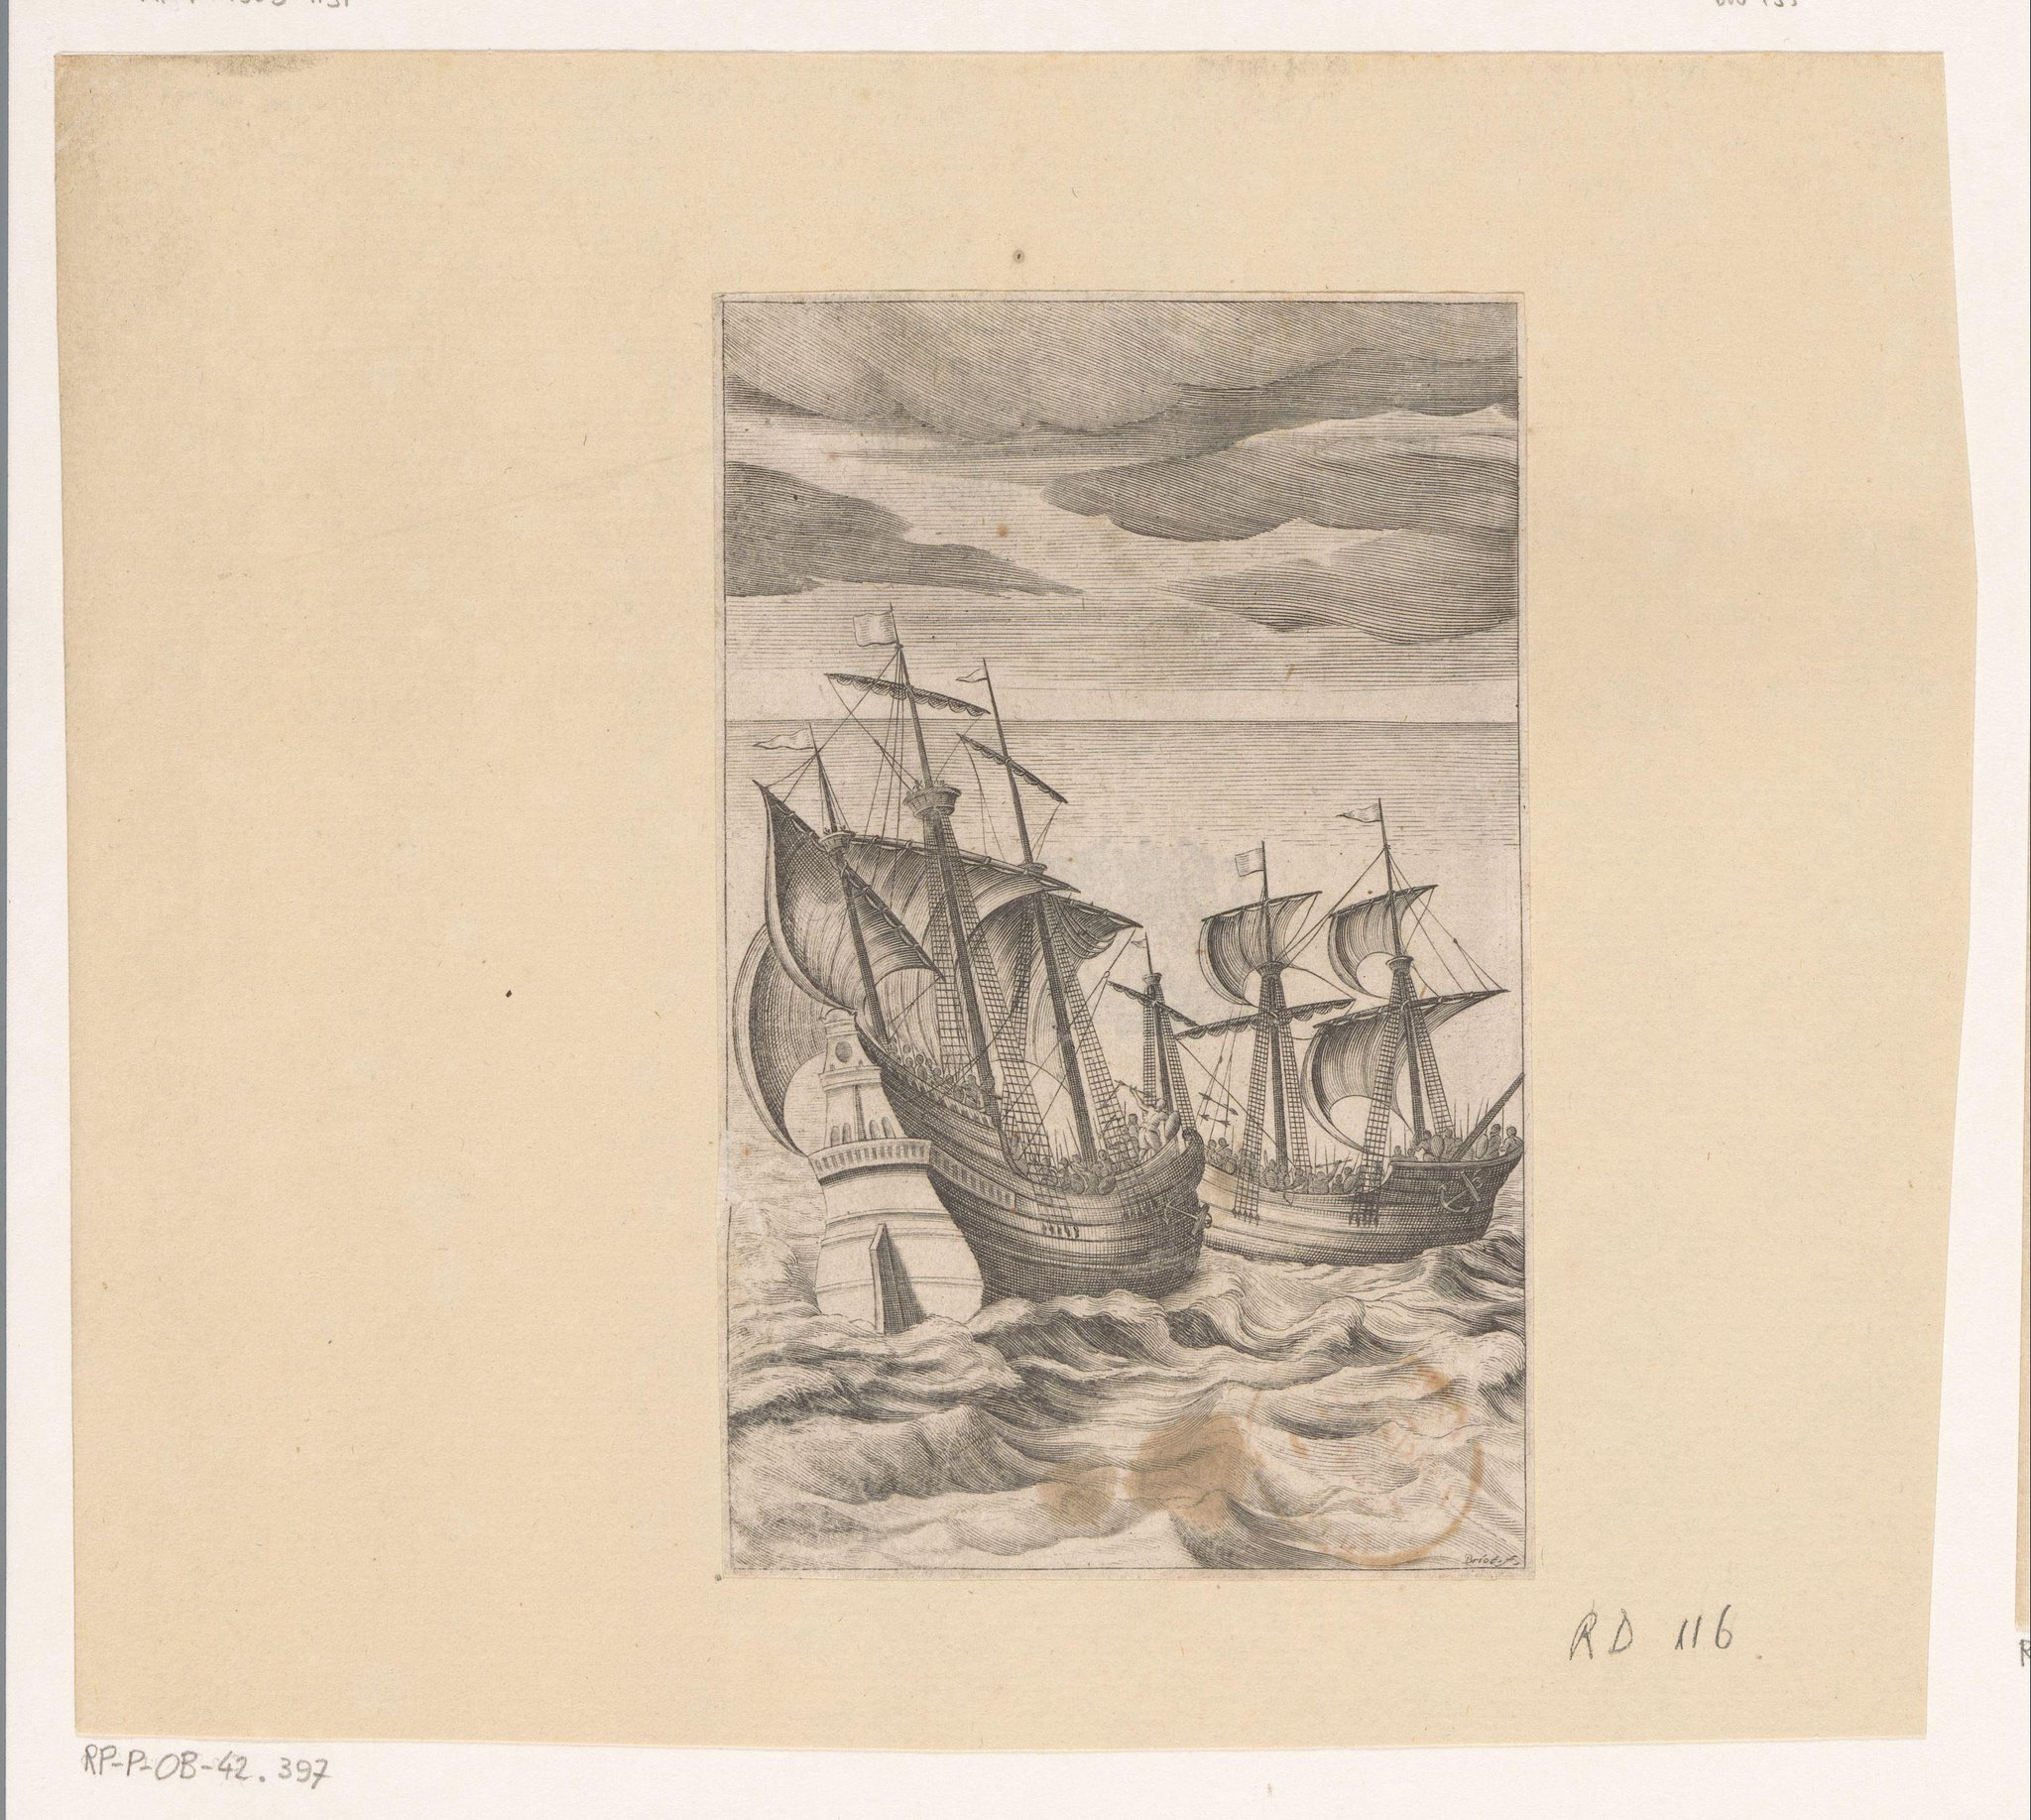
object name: book illustration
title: Calasiris en de twee geliefden door piraten op zee aangevallen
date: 1628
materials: paper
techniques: engraving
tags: battle (+ naval force), pirate(ship), classical mythology and ancient history, sea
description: Prent uit: Les Amours de Theagène et Chariclee. Histoire Ethiopique d'Heliodore. Tweede druk. Parijs: Samuel Thiboust, 1628.